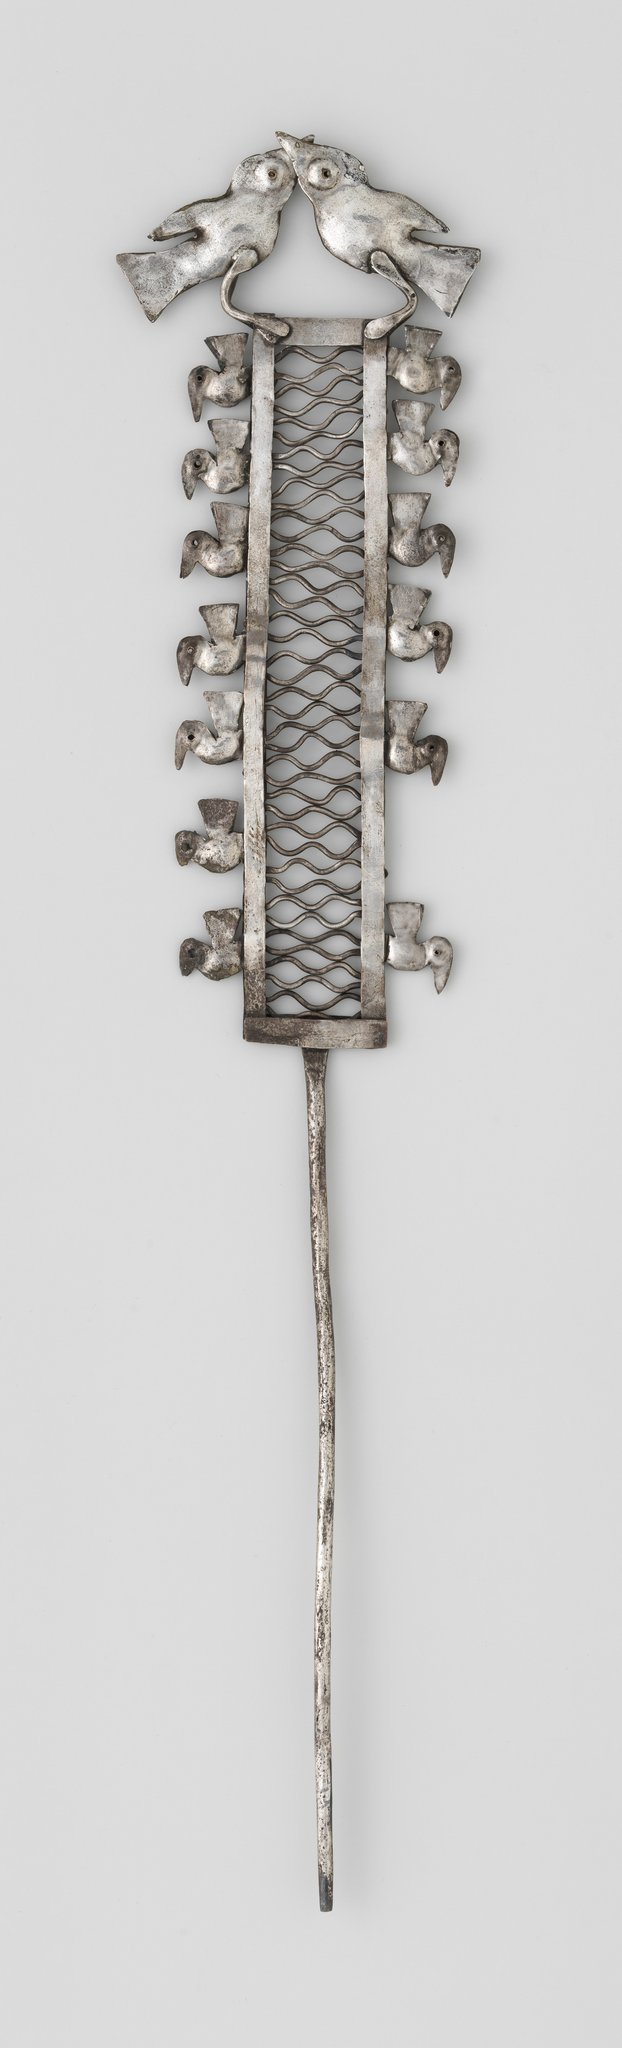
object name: pin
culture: chancay or chimú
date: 1301-1500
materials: silver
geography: peru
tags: birds